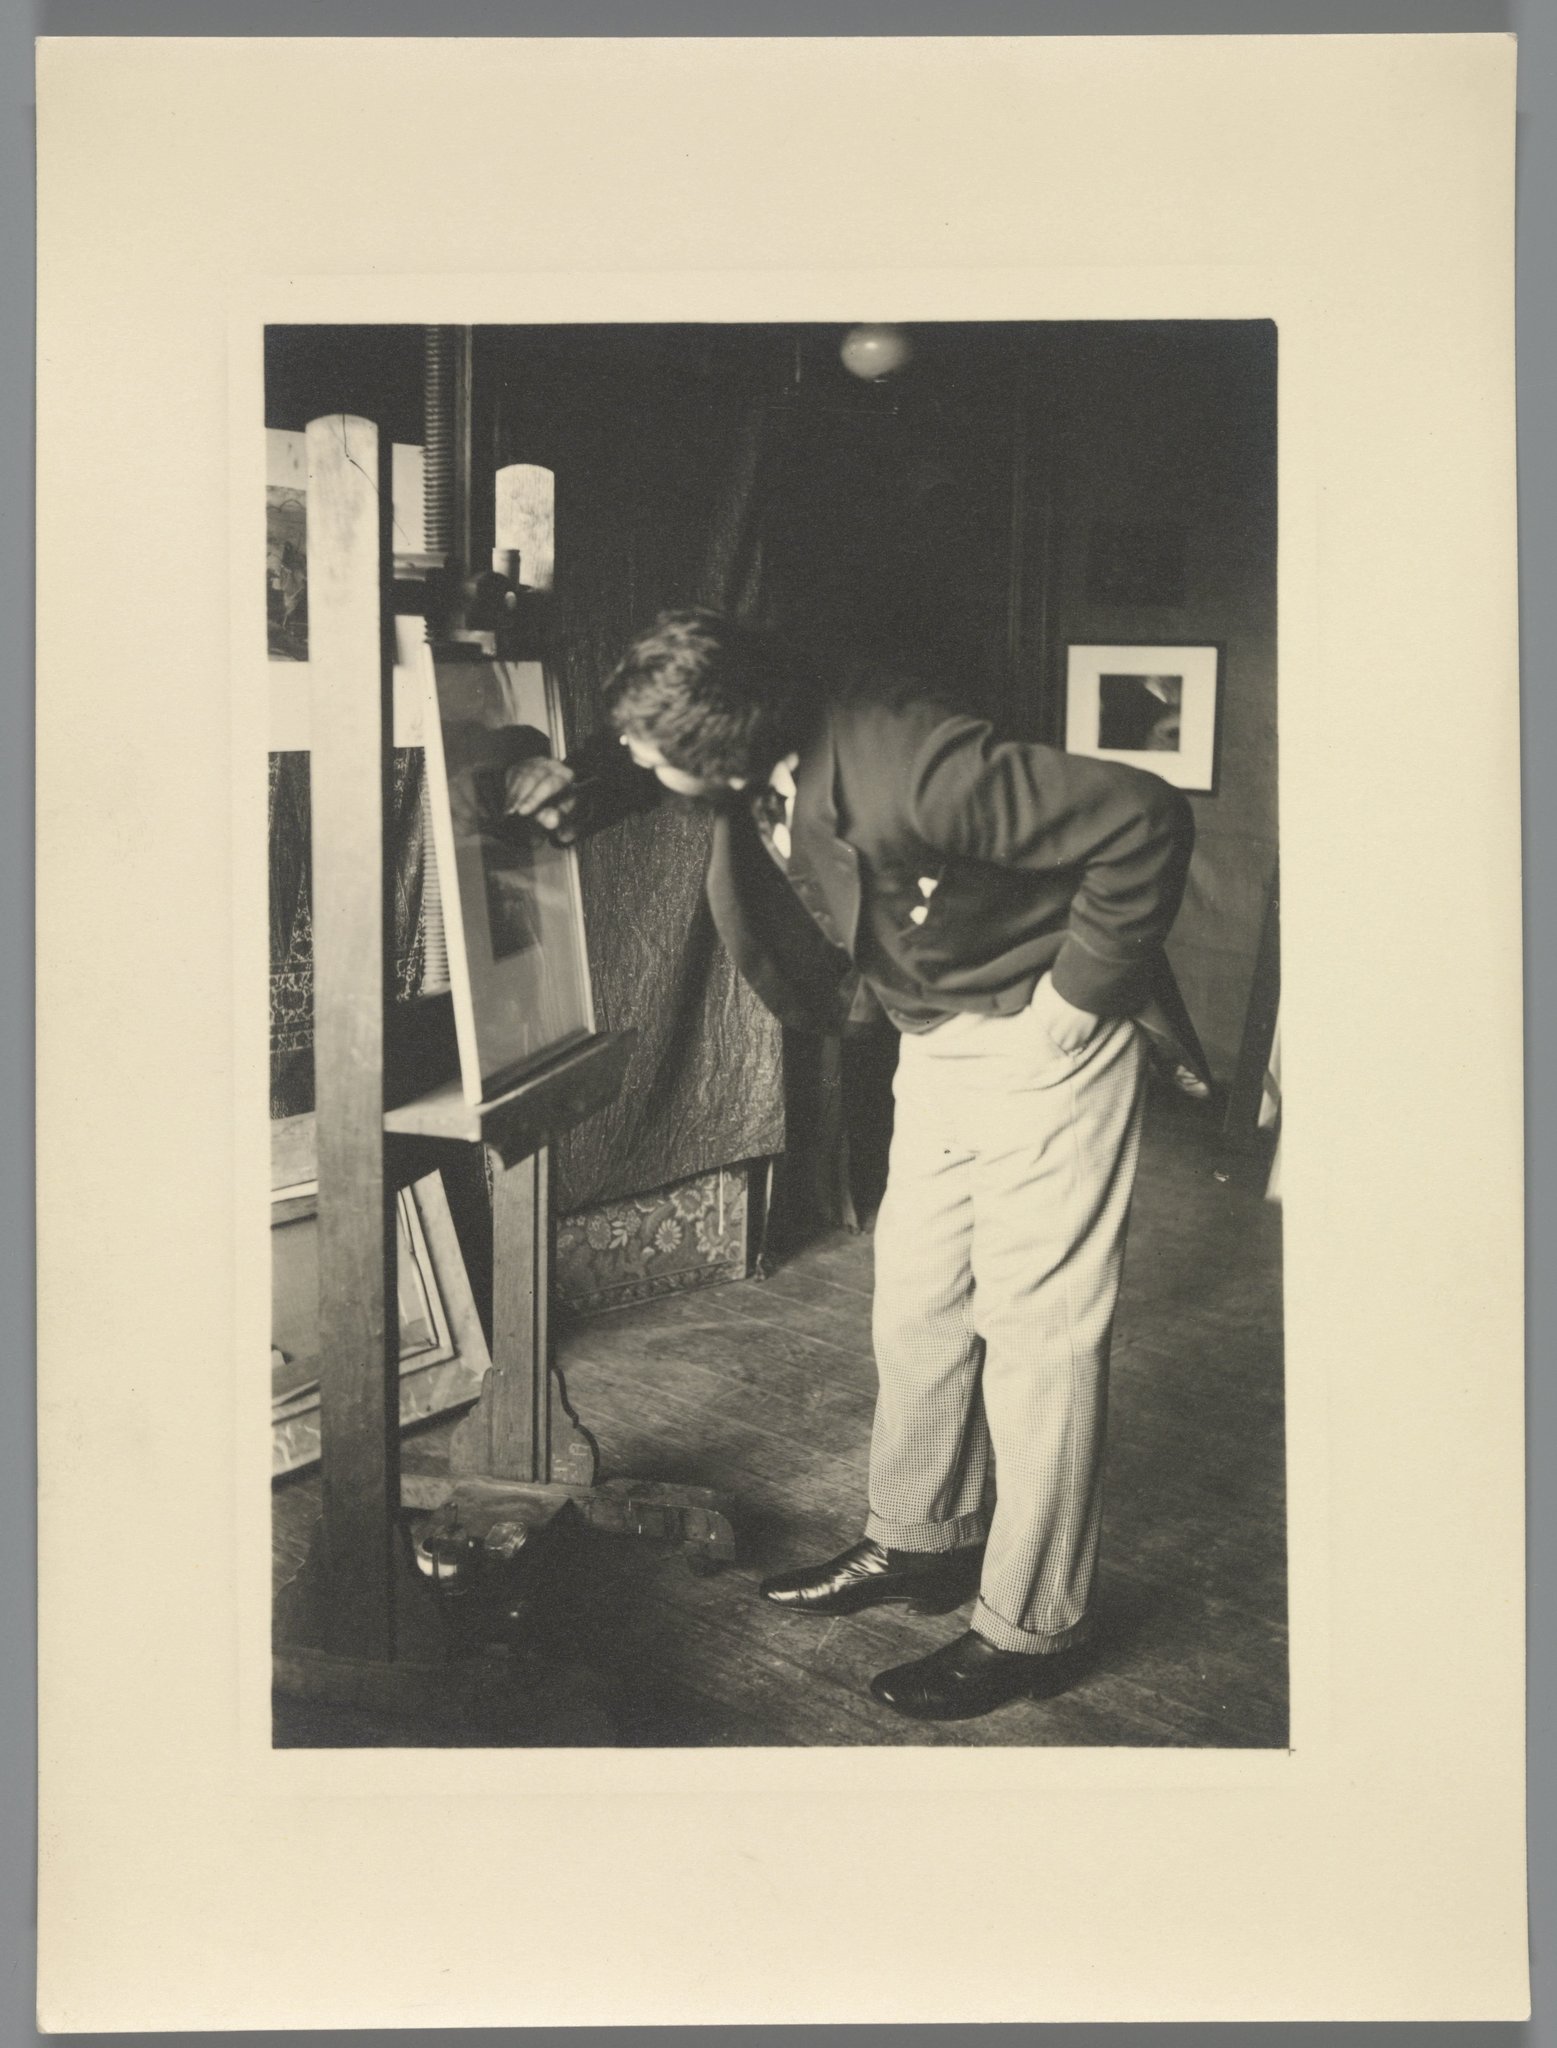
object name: photograph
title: Reproductie naar een foto van Willem Witsen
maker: Anonymous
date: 1860-1915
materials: paper, photographic support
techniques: gelatin silver print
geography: netherlands